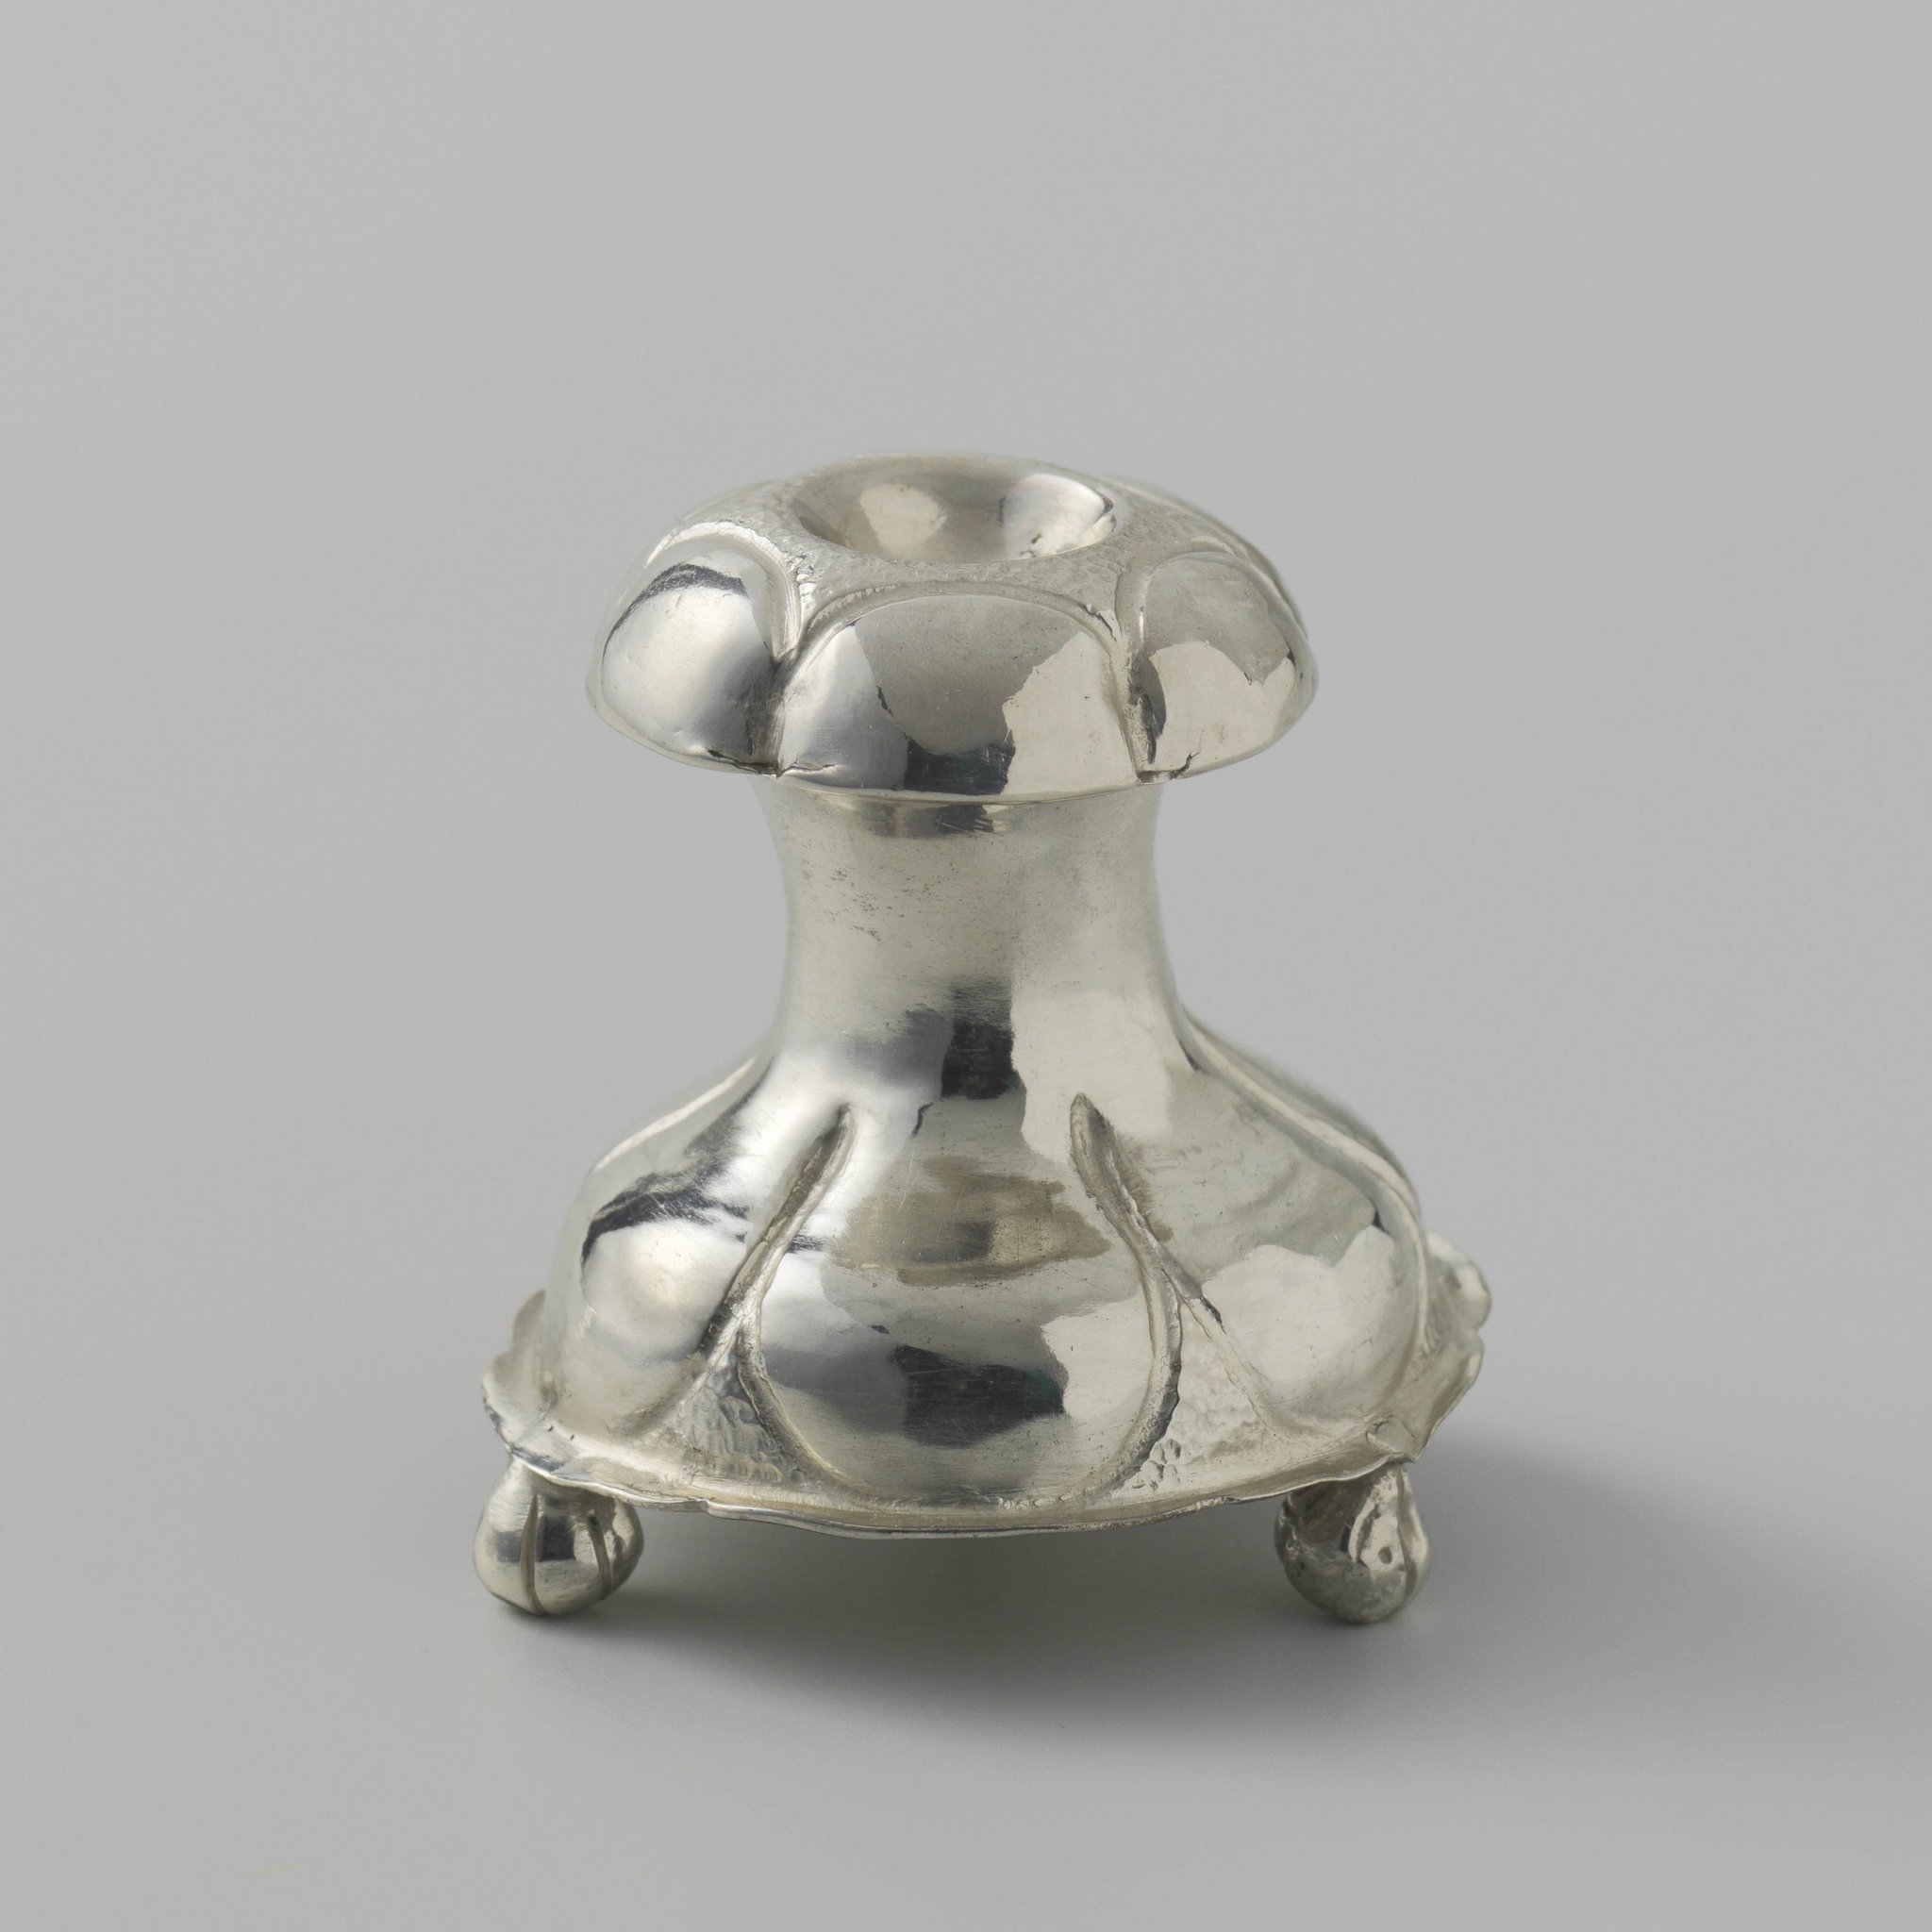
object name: miniature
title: Zoutvat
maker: Anonymous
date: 1650-1675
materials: silver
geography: netherlands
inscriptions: maker's mark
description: Diabolo-vormig zoutvat op drie bolpoten. Het zoutvat is versierd met geruwde delen tussen gladde blazen. Het zoutvat is gemerkt: mt.= Voet 158.